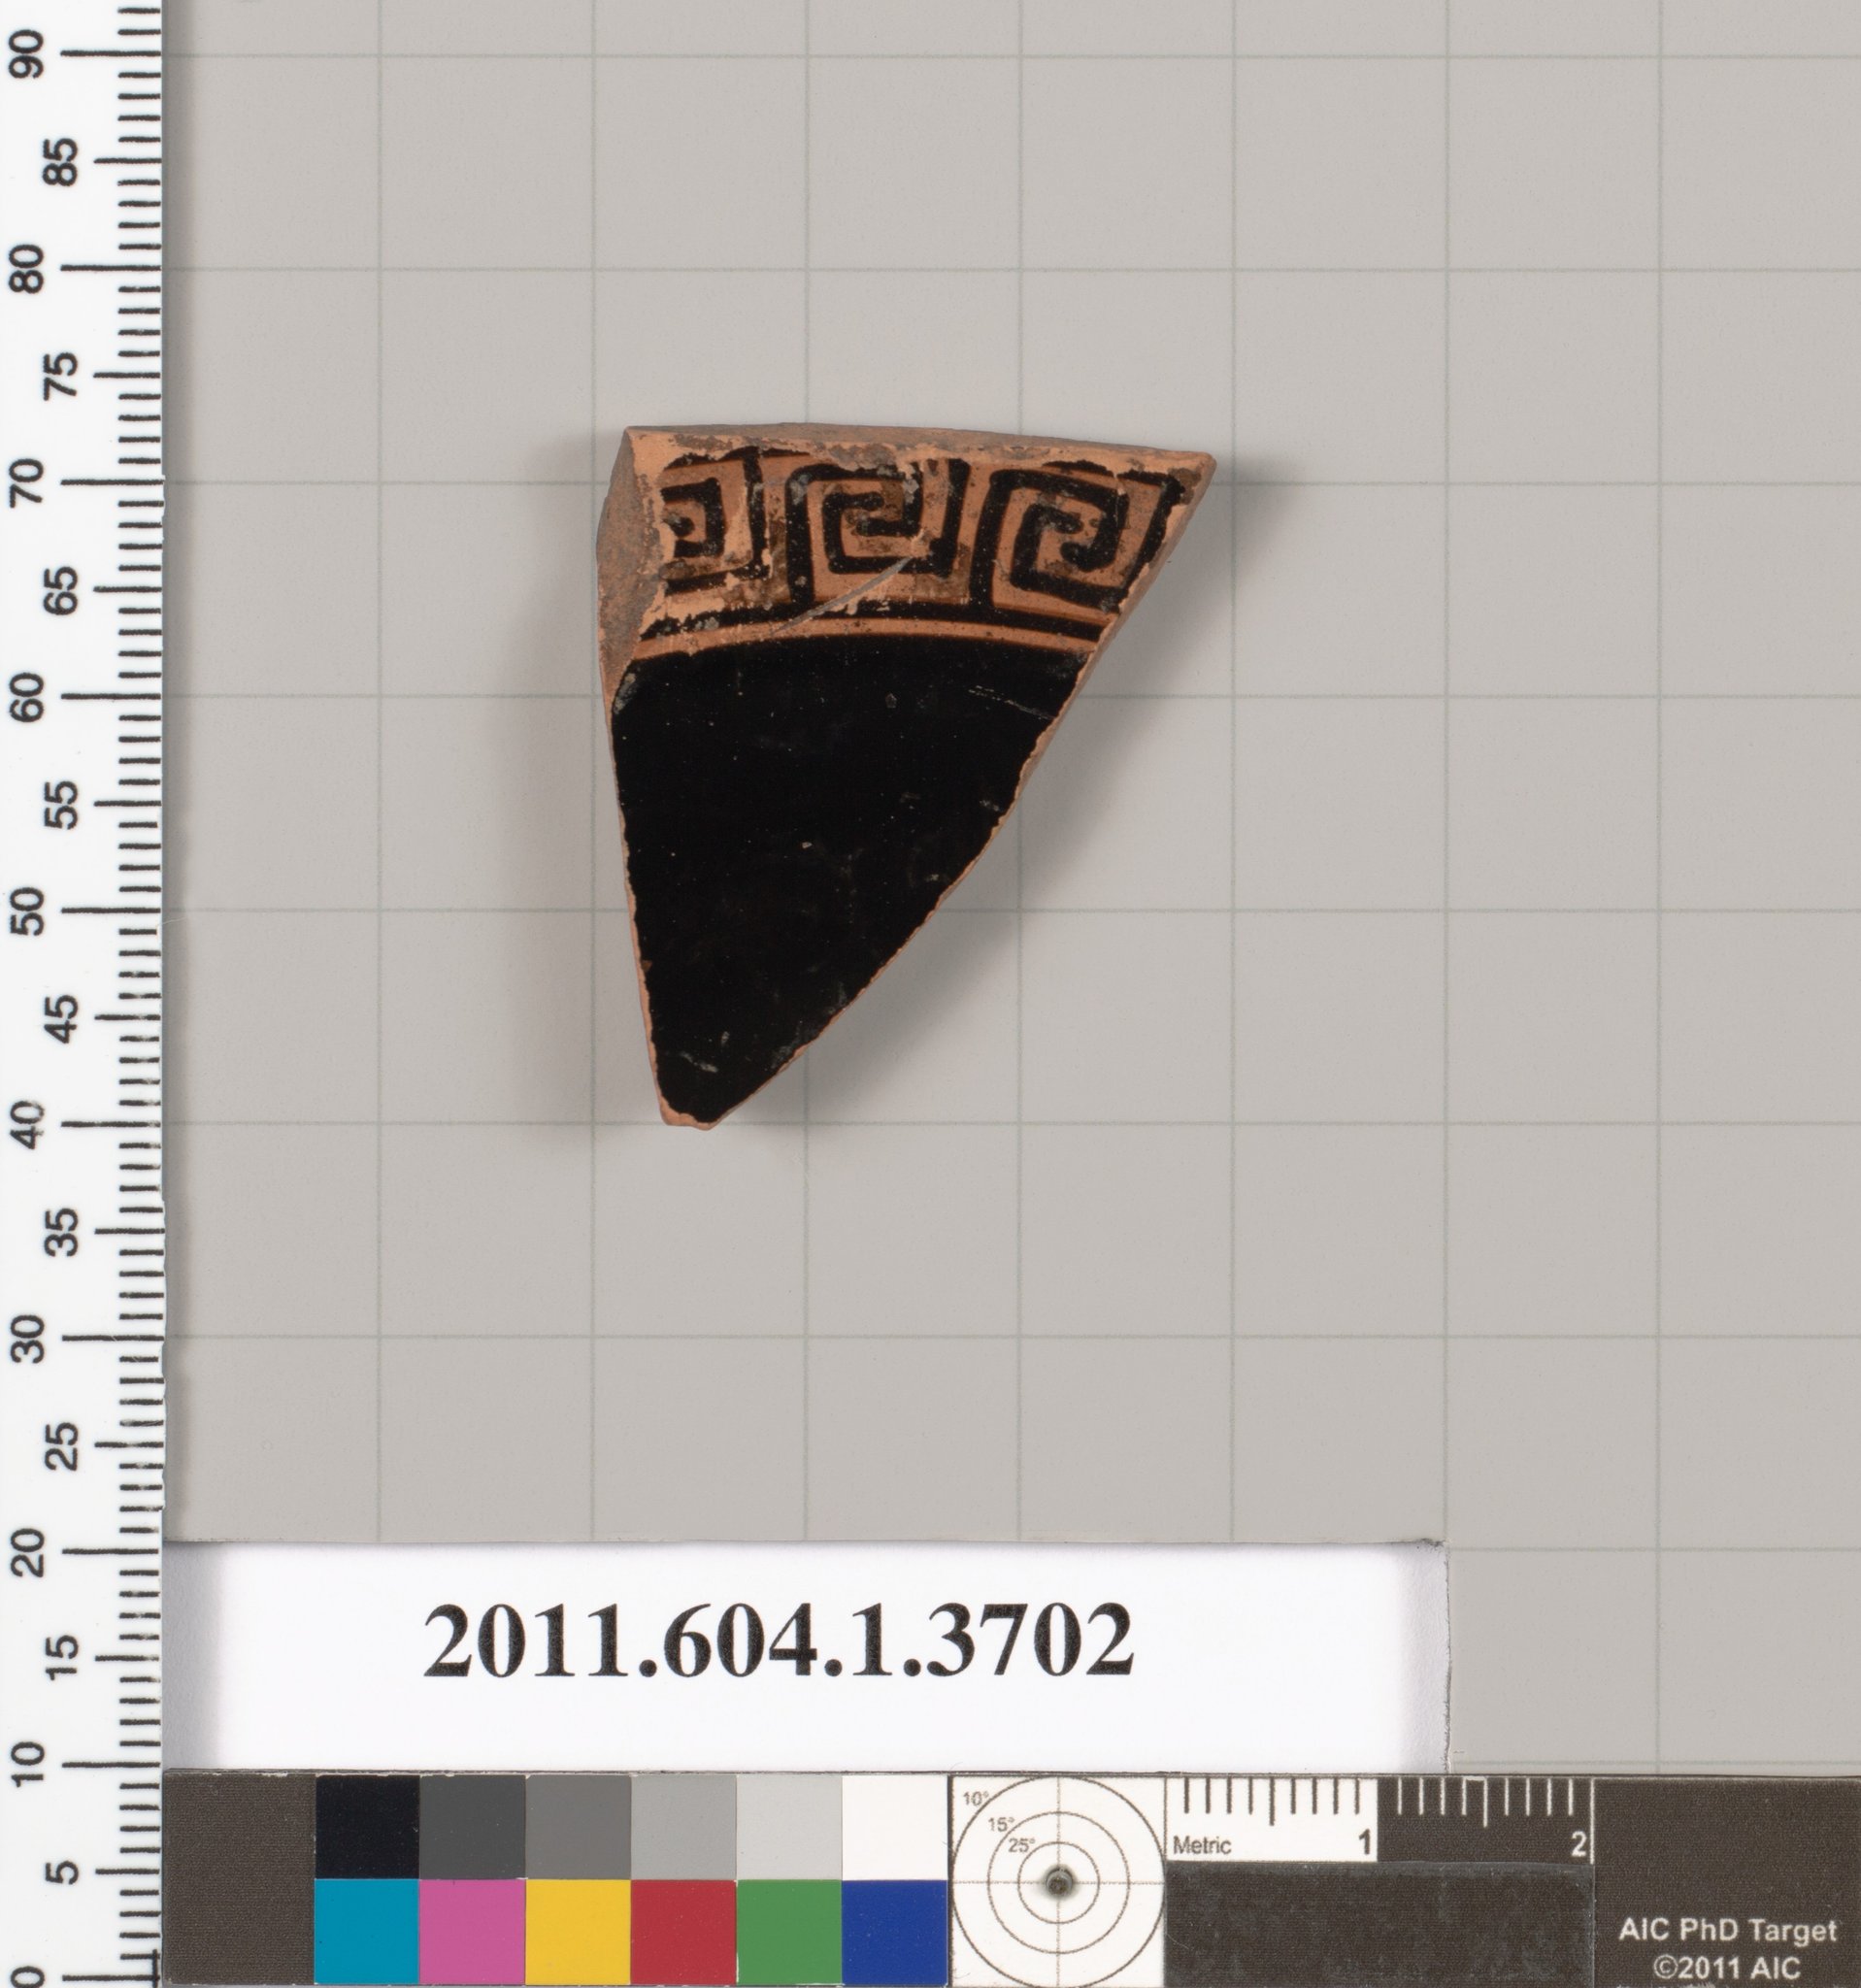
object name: kylix fragment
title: Terracotta fragment of a kylix (drinking cup)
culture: greek, attic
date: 500-470 BCE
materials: terracotta